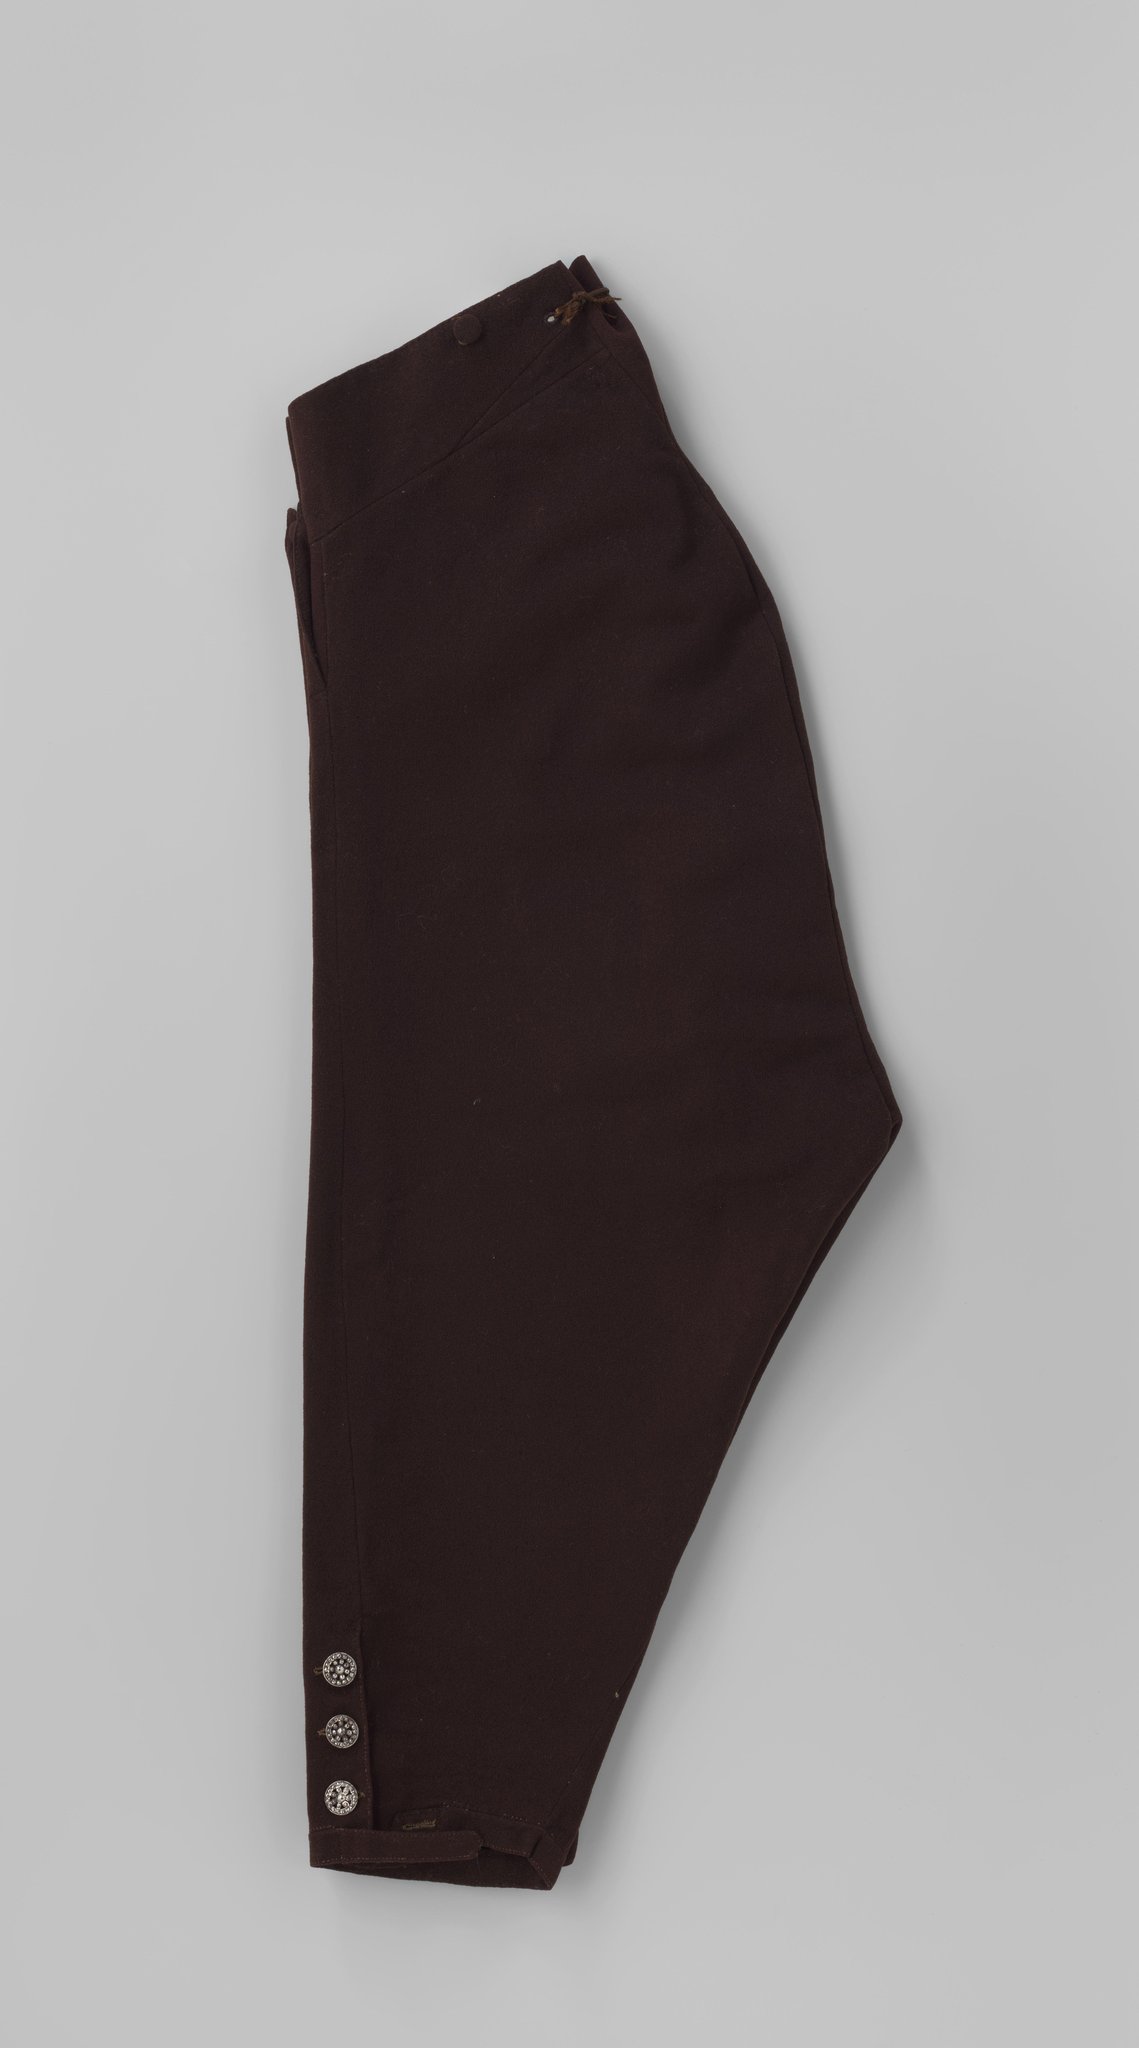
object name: pant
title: Court Costume or Full Dress Costume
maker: Anonymous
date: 1815-1830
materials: textile, silk, steel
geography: netherlands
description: Officials were expected to wear a full dress costume at the court of King William I of the Netherlands. There was one for every occasion. The king determined what it looked like and drew inspiration from the period he spent in exile in England. This is evident from the stiff raised collar worn with a cravat, and the white piping of the suit.